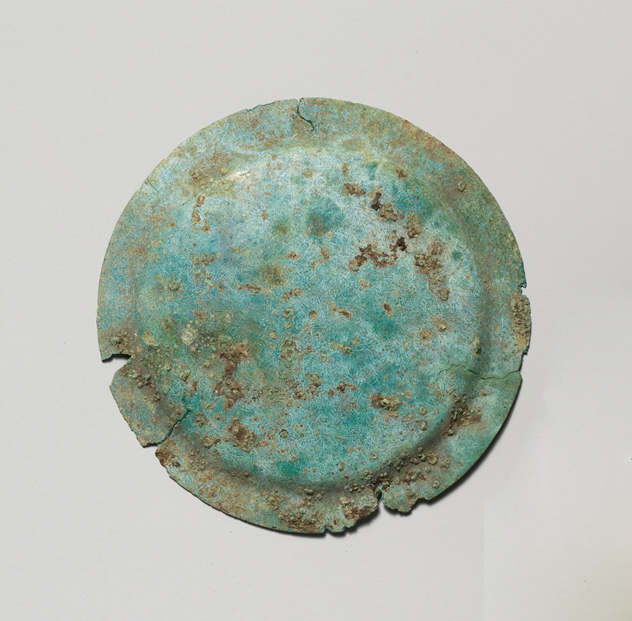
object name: shield, miniature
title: Miniature bronze shield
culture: etruscan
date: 500-401 BCE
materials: bronze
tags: shields